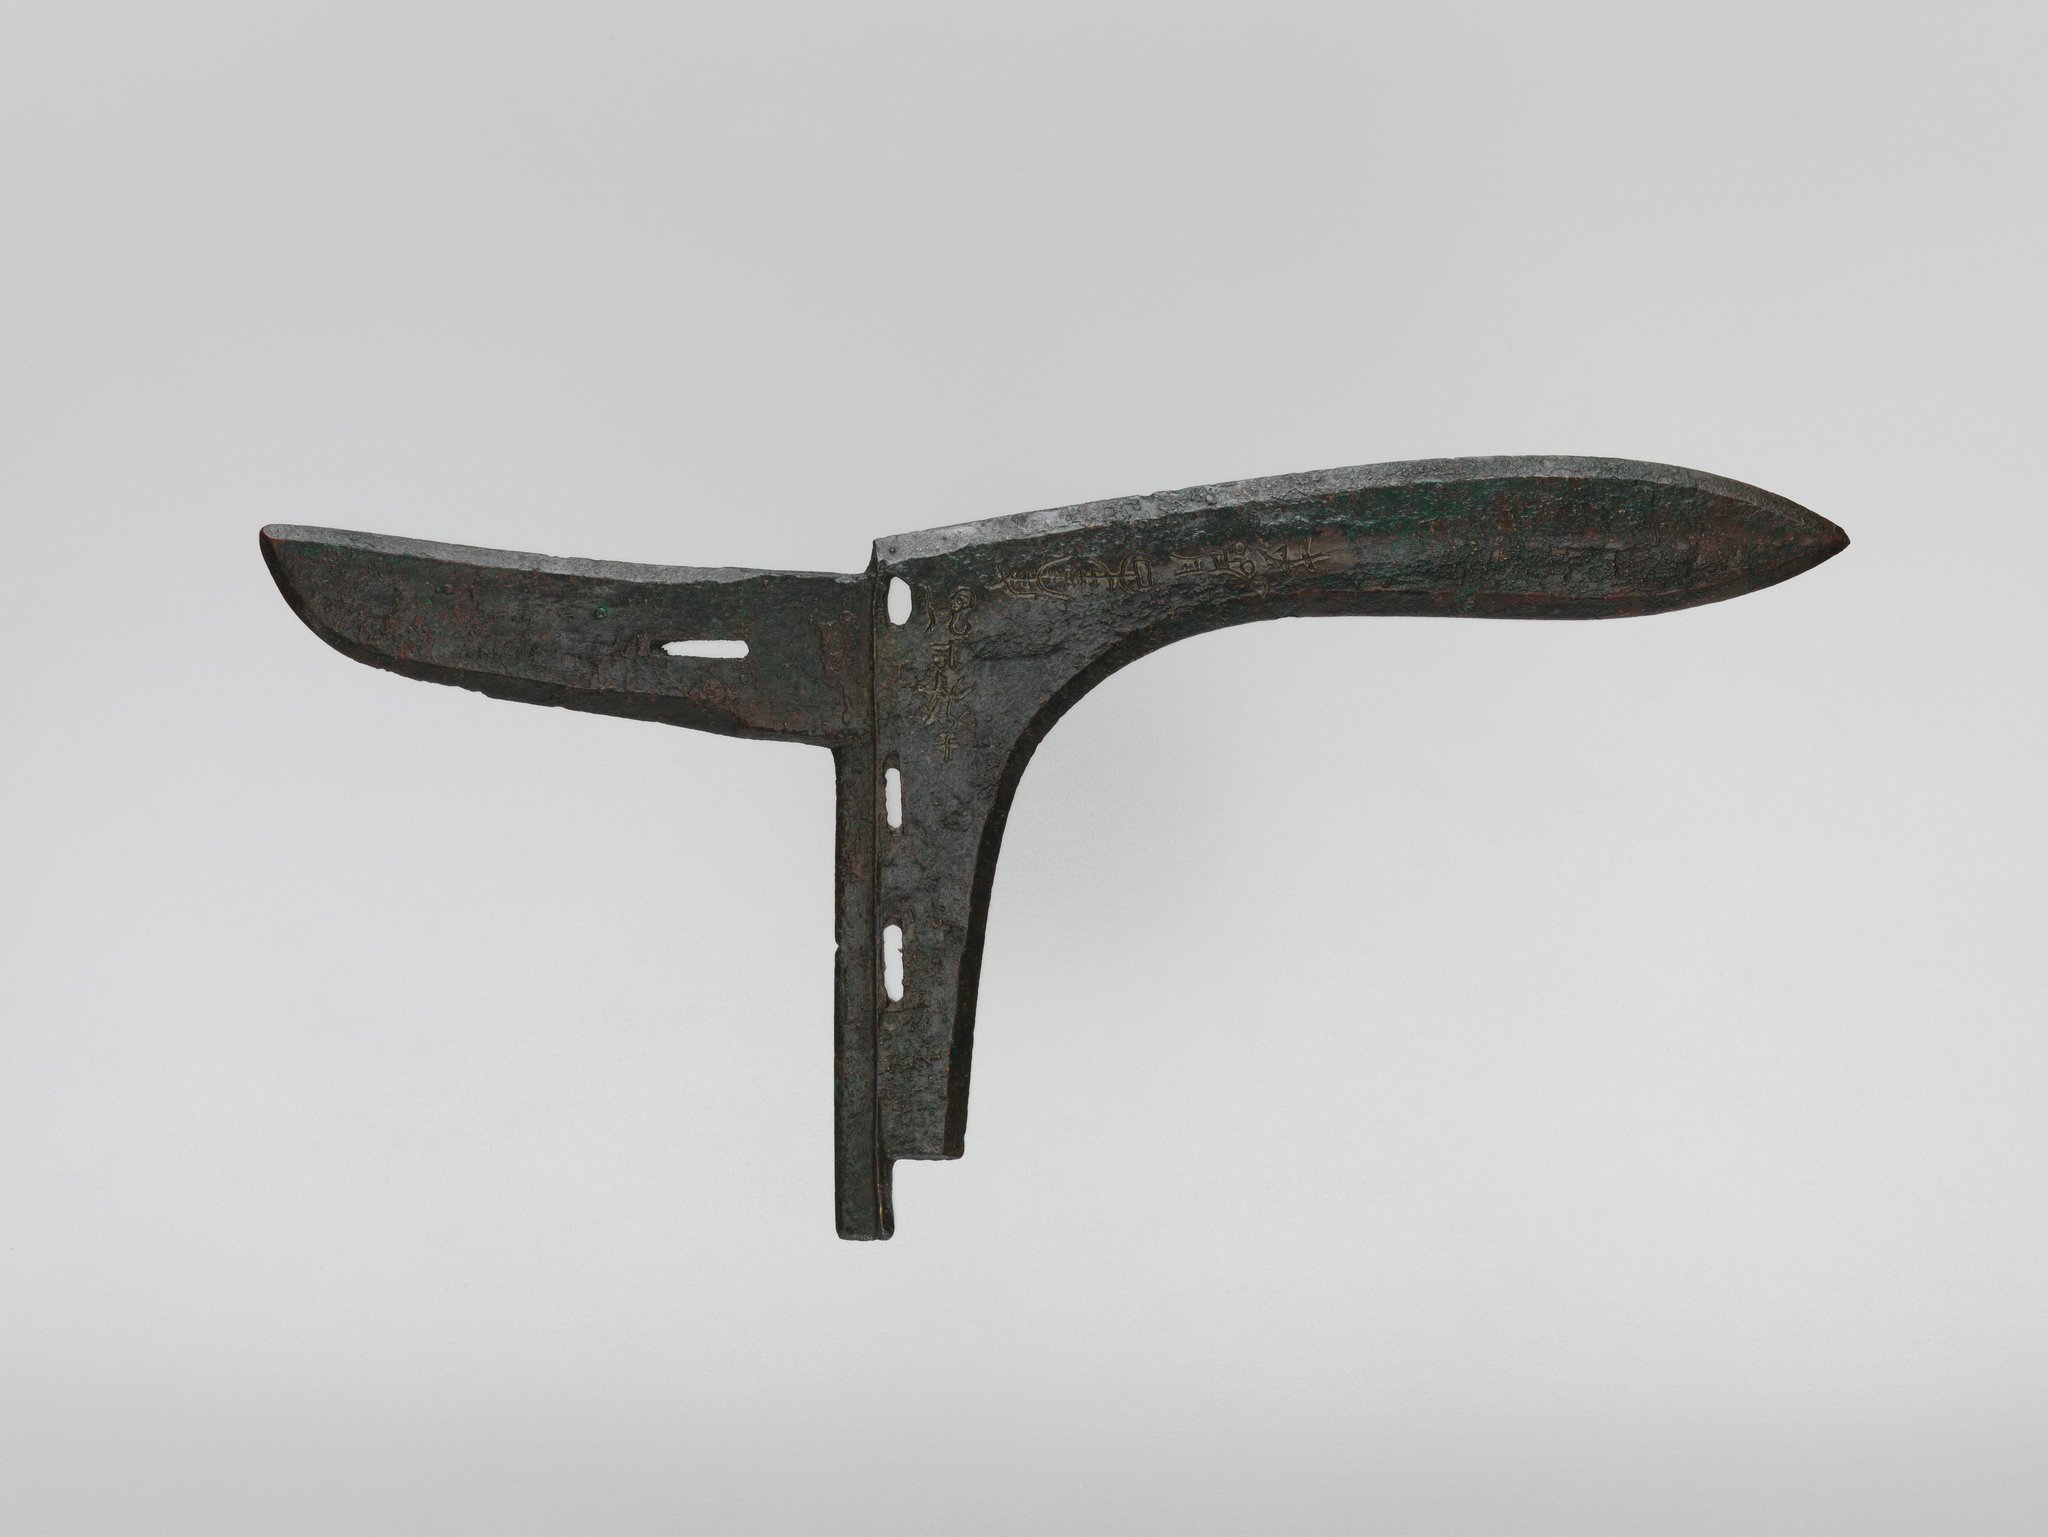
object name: dagger ax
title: Dagger-Ax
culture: chinese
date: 1046-256 BCE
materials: bronze